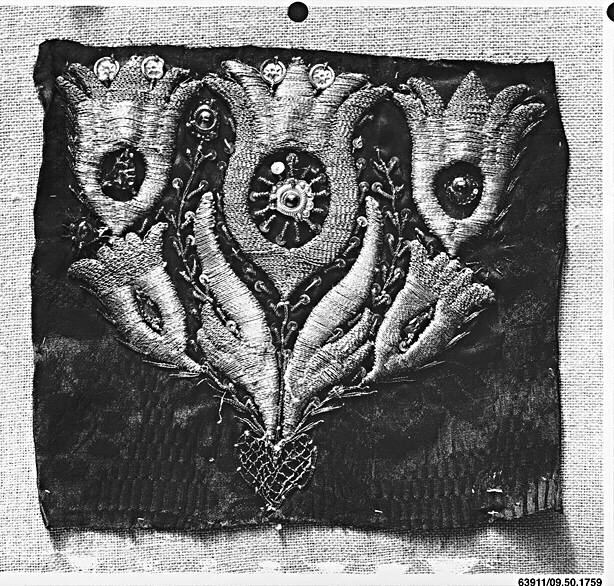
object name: fragment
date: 1701-1800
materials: metal thread, silk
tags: flowers